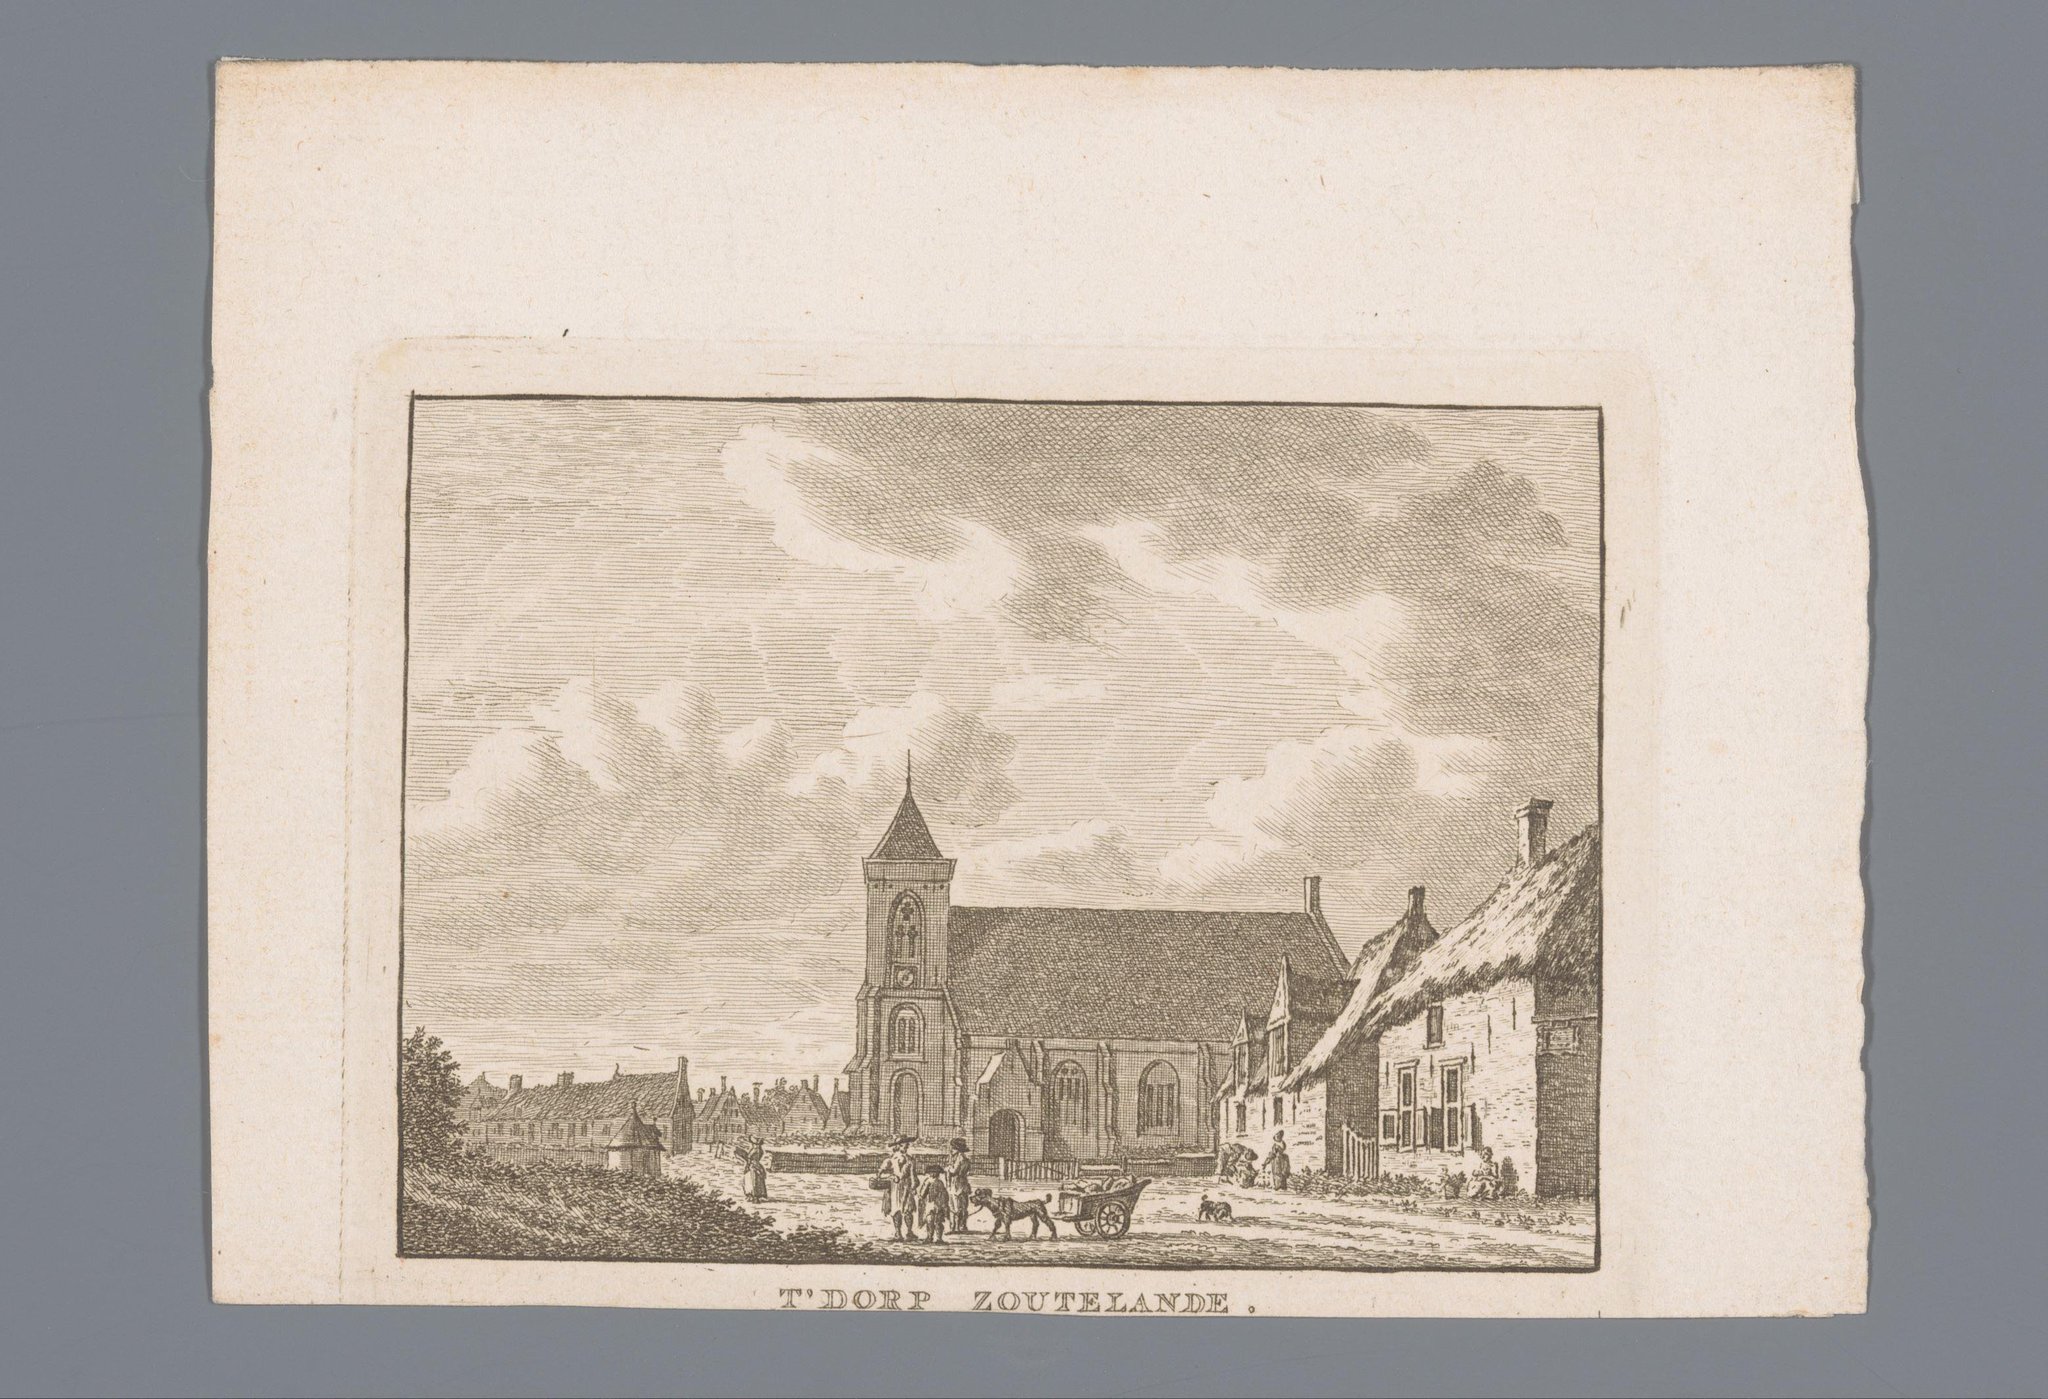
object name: print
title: Gezicht op de Catharinakerk in het dorp Zoutelande in Zeeland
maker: carel frederik bendorp (i)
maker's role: print maker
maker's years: 1736-1814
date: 1786-1792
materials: paper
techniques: etching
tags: church (exterior), village (+ city(-scape) with figures, staffage)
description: Prent uit: Vaderlandsche gezichten, of afbeeldingen van den tegenwoordigen staat der Vereenigde Nederlanden (…). Amsterdam: Hendrik Gartman, Willem Vermandel en Jan Willem Smit, 1786-1792. Uitgegeven in afleveringen met ieder een eigen bifolium en inhoudsopgave. Alle prenten in deze publicatie zijn gegraveerd door Carel Frederik Bendorp (I) en, in de meeste gevallen, gebaseerd op tekeningen van Jan Bulthuis.